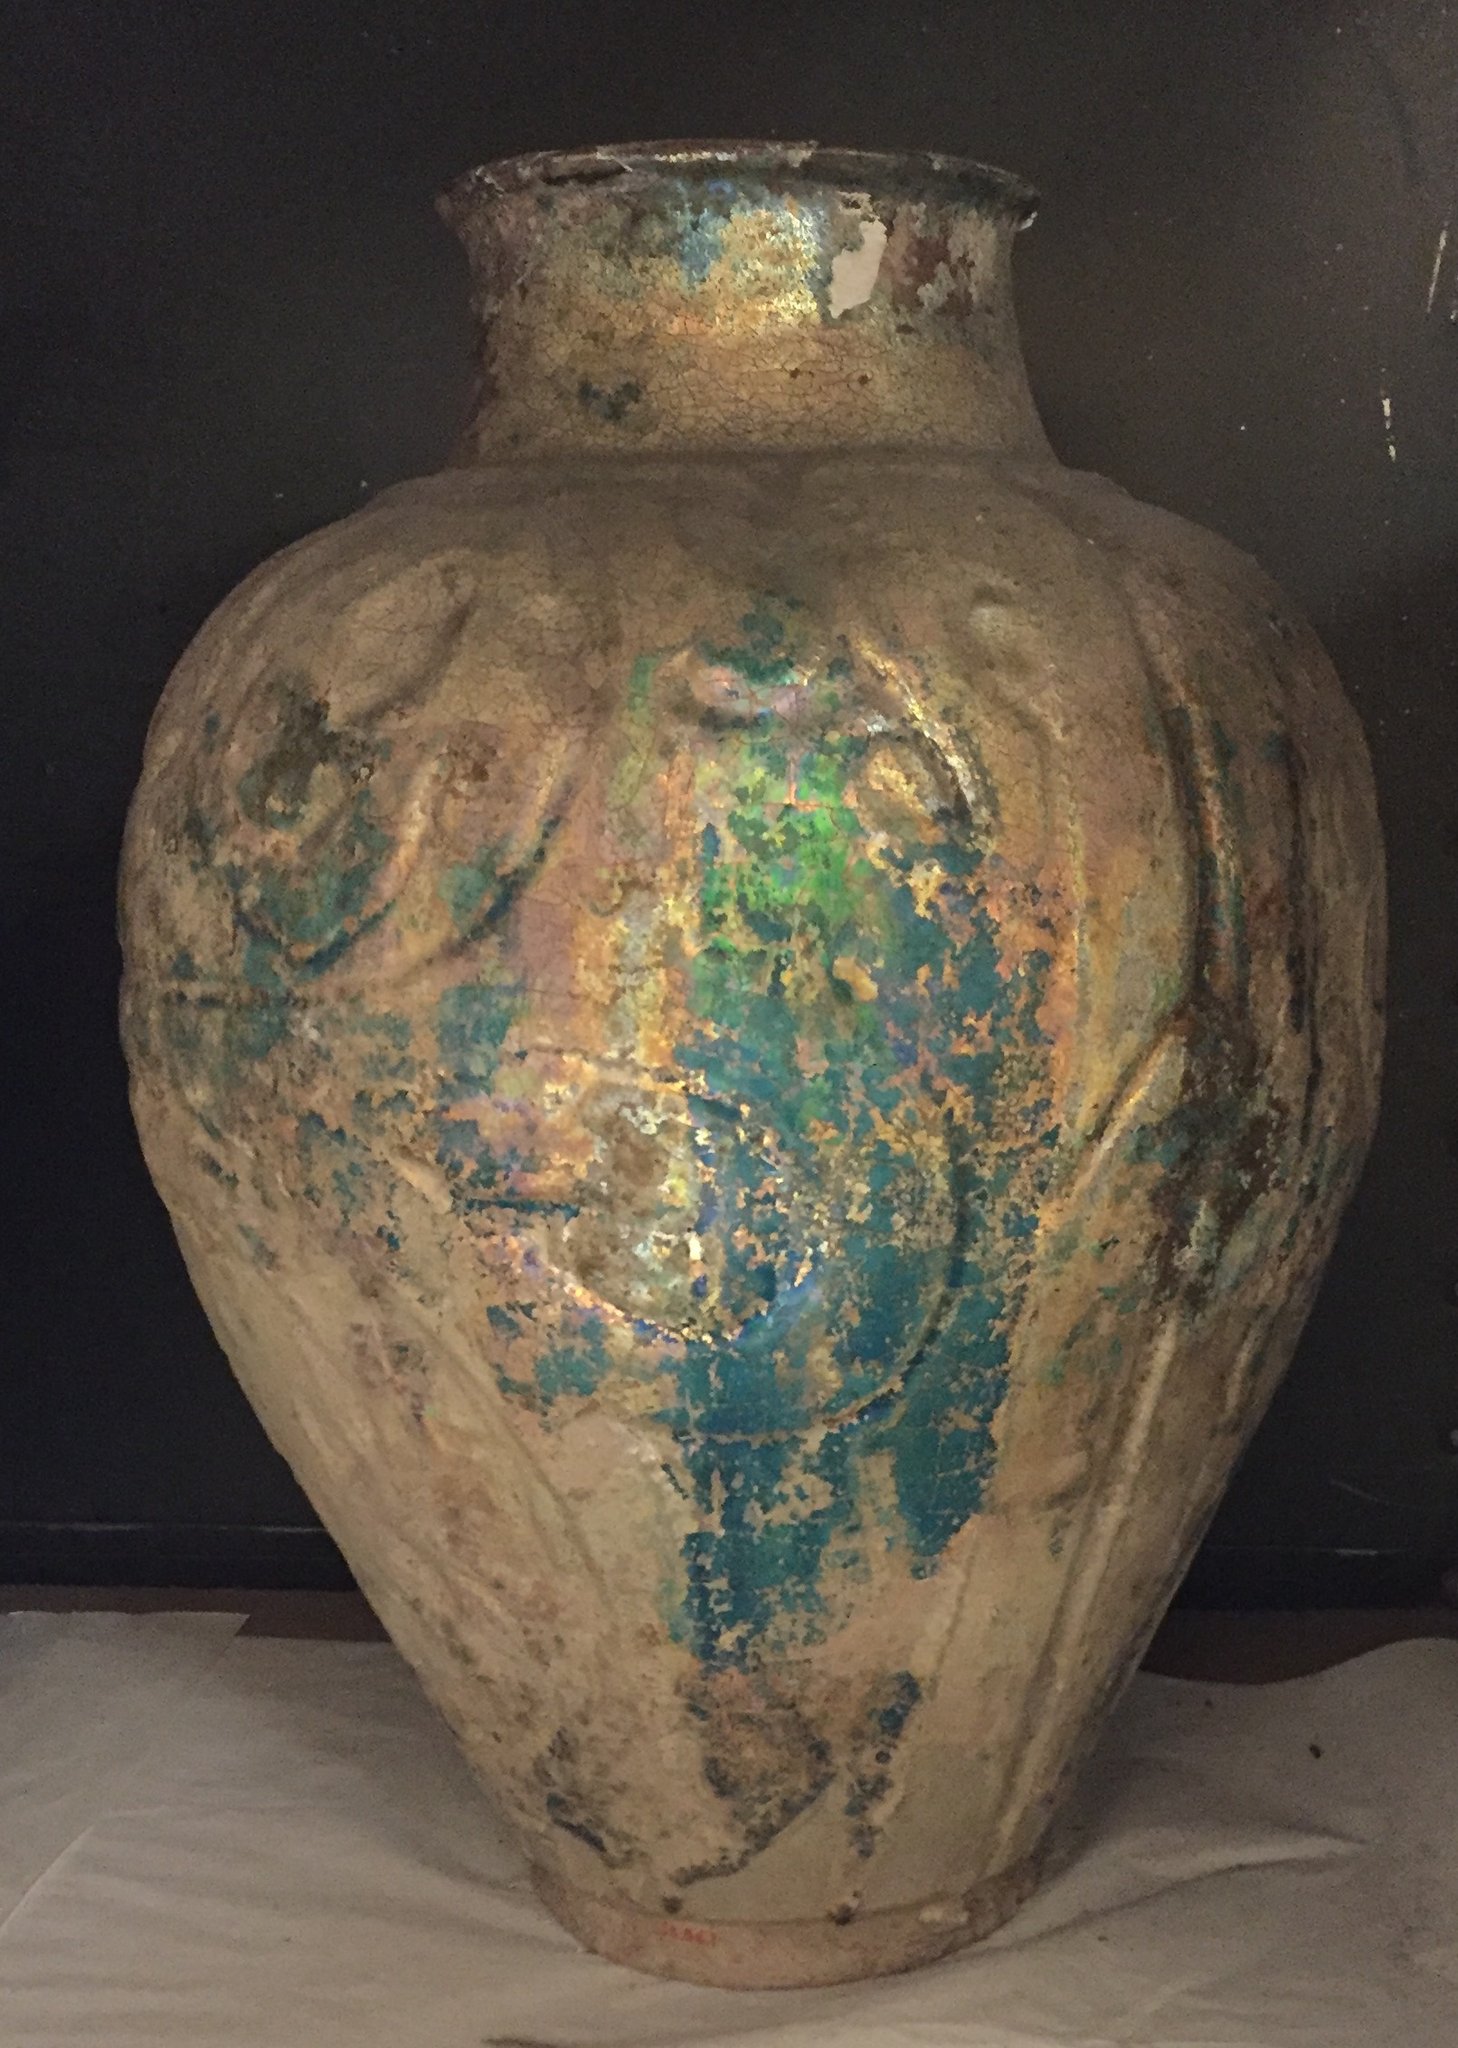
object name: jar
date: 1101-1200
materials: earthenware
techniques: glazing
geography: syria